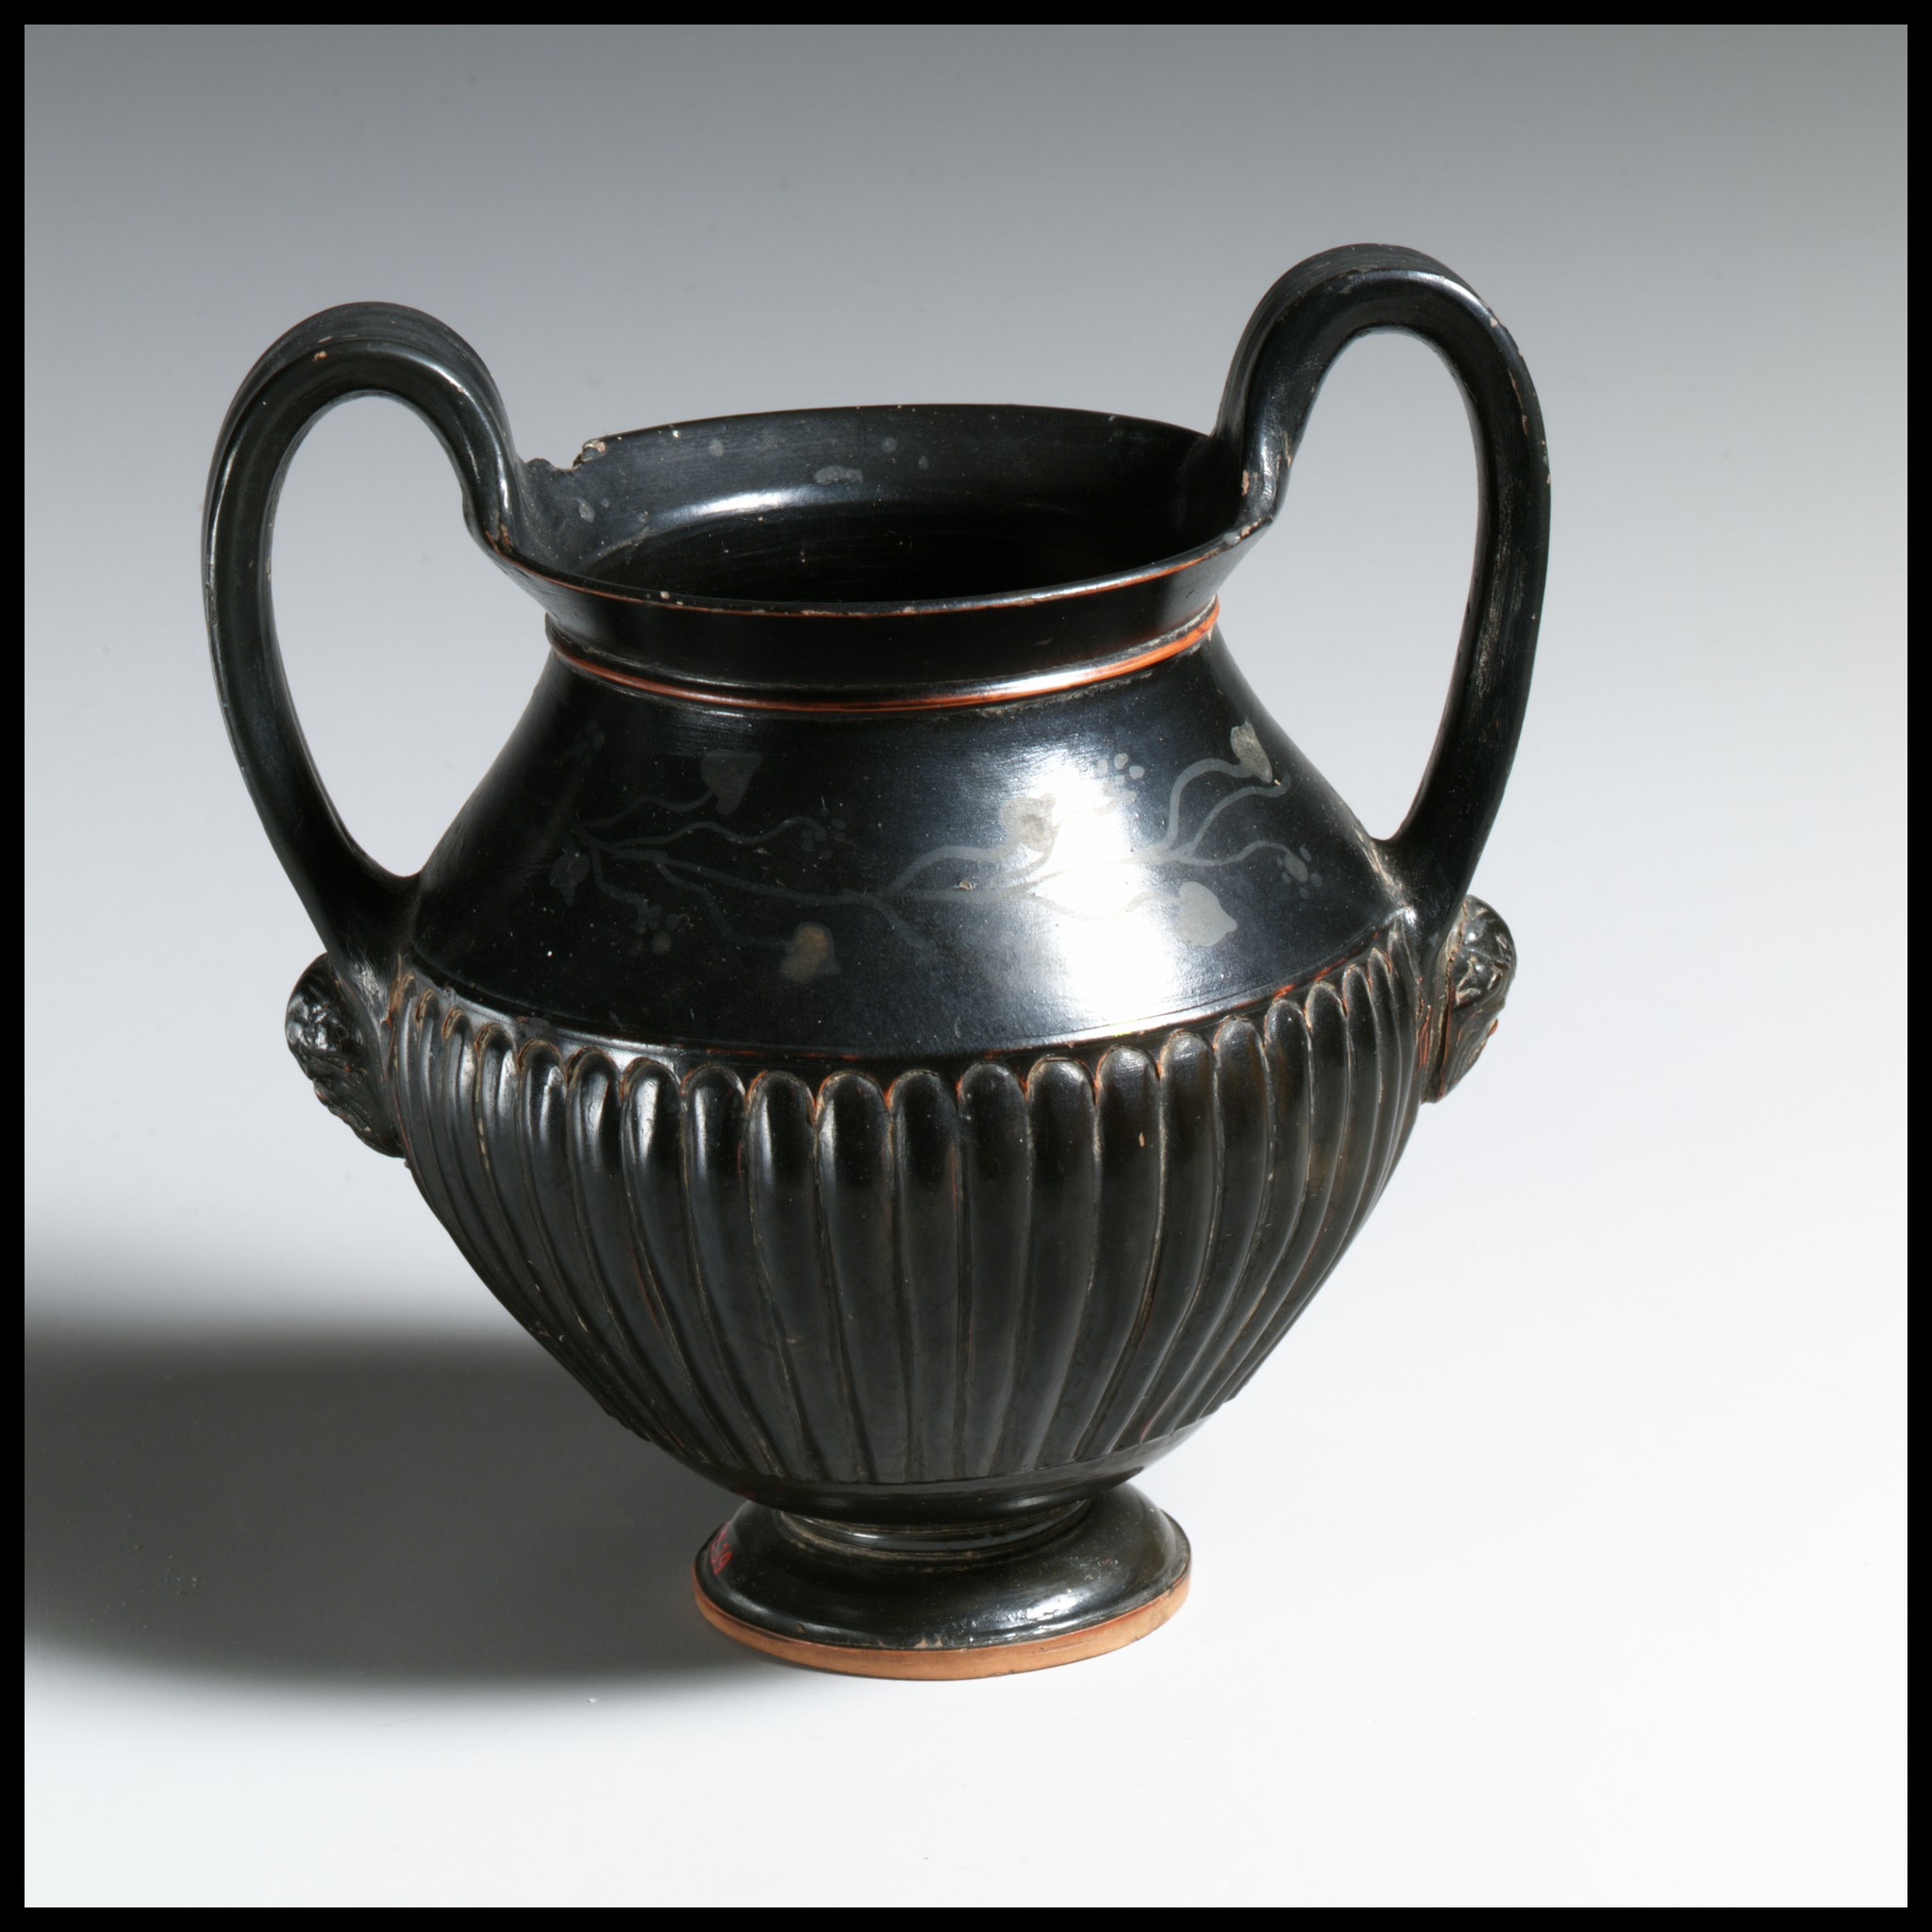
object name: kantharos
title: Terracotta kantharos (drinking cup with high handles)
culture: greek, south italian, apulian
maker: xenon group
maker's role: artist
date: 400-350 BCE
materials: terracotta